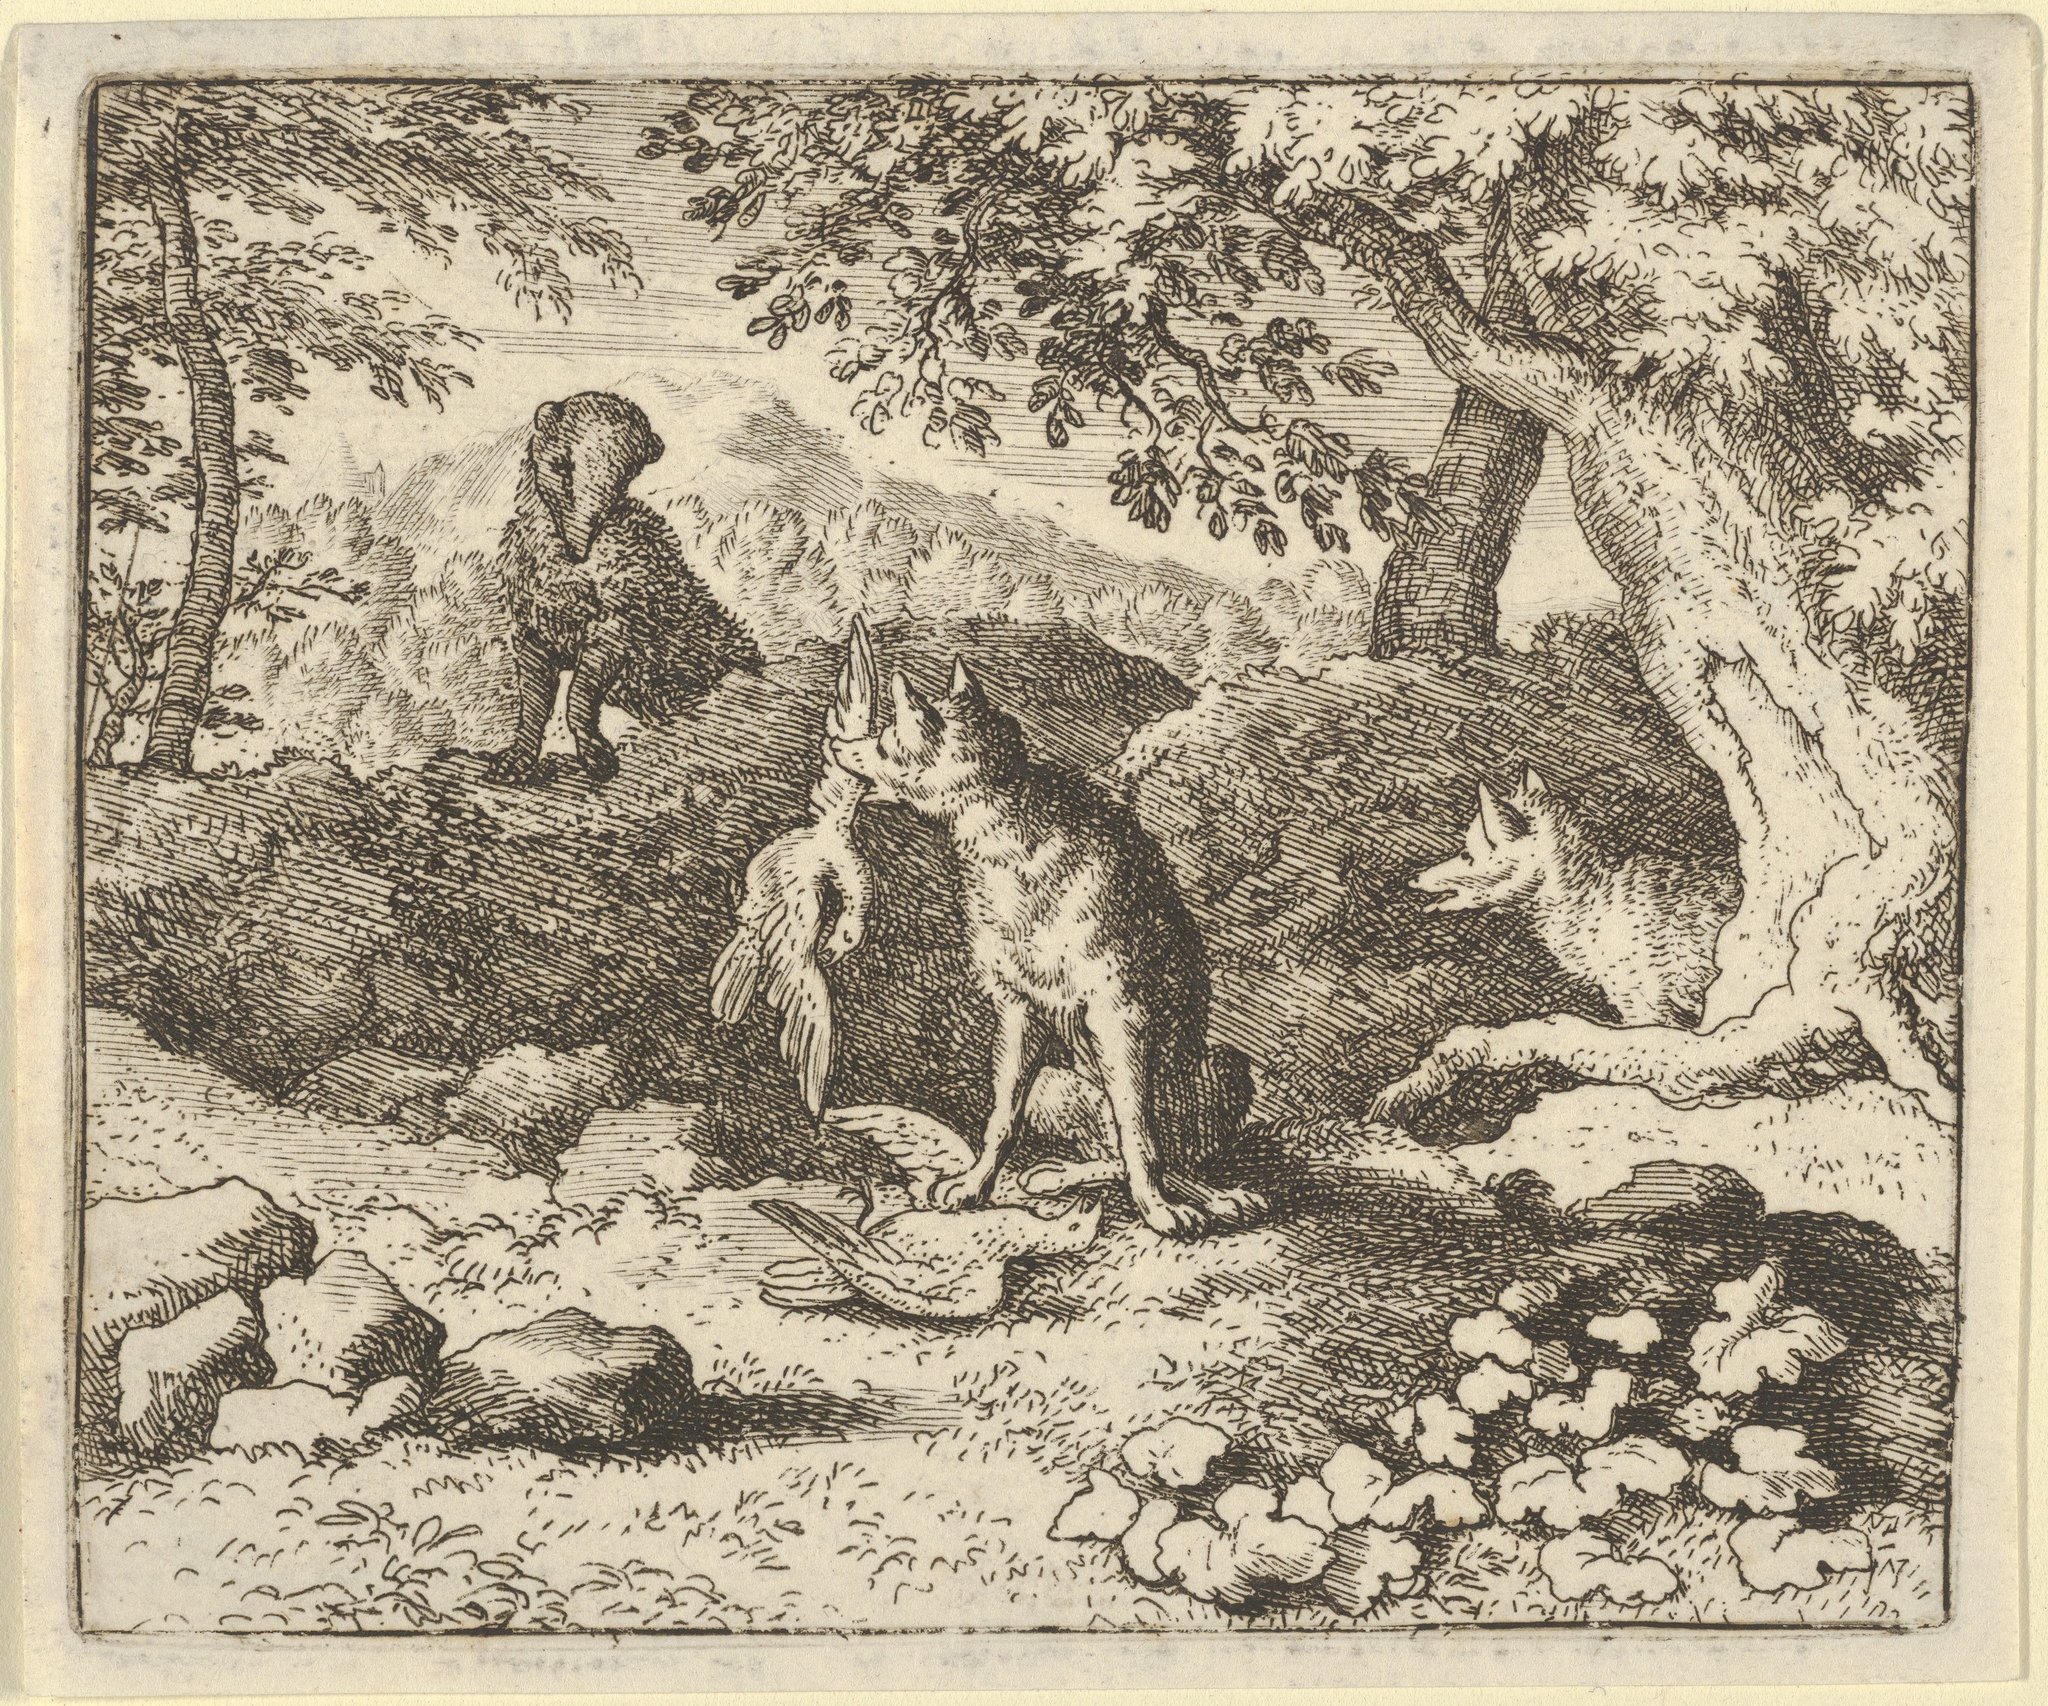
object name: print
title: The Badger Hurries to Warn Renard of the Lion's Intention from Hendrick van Alcmar's Renard The Fox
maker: allart van everdingen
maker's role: artist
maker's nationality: dutch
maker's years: 1621-1675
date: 1650-1675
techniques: engraving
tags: birds,foxes